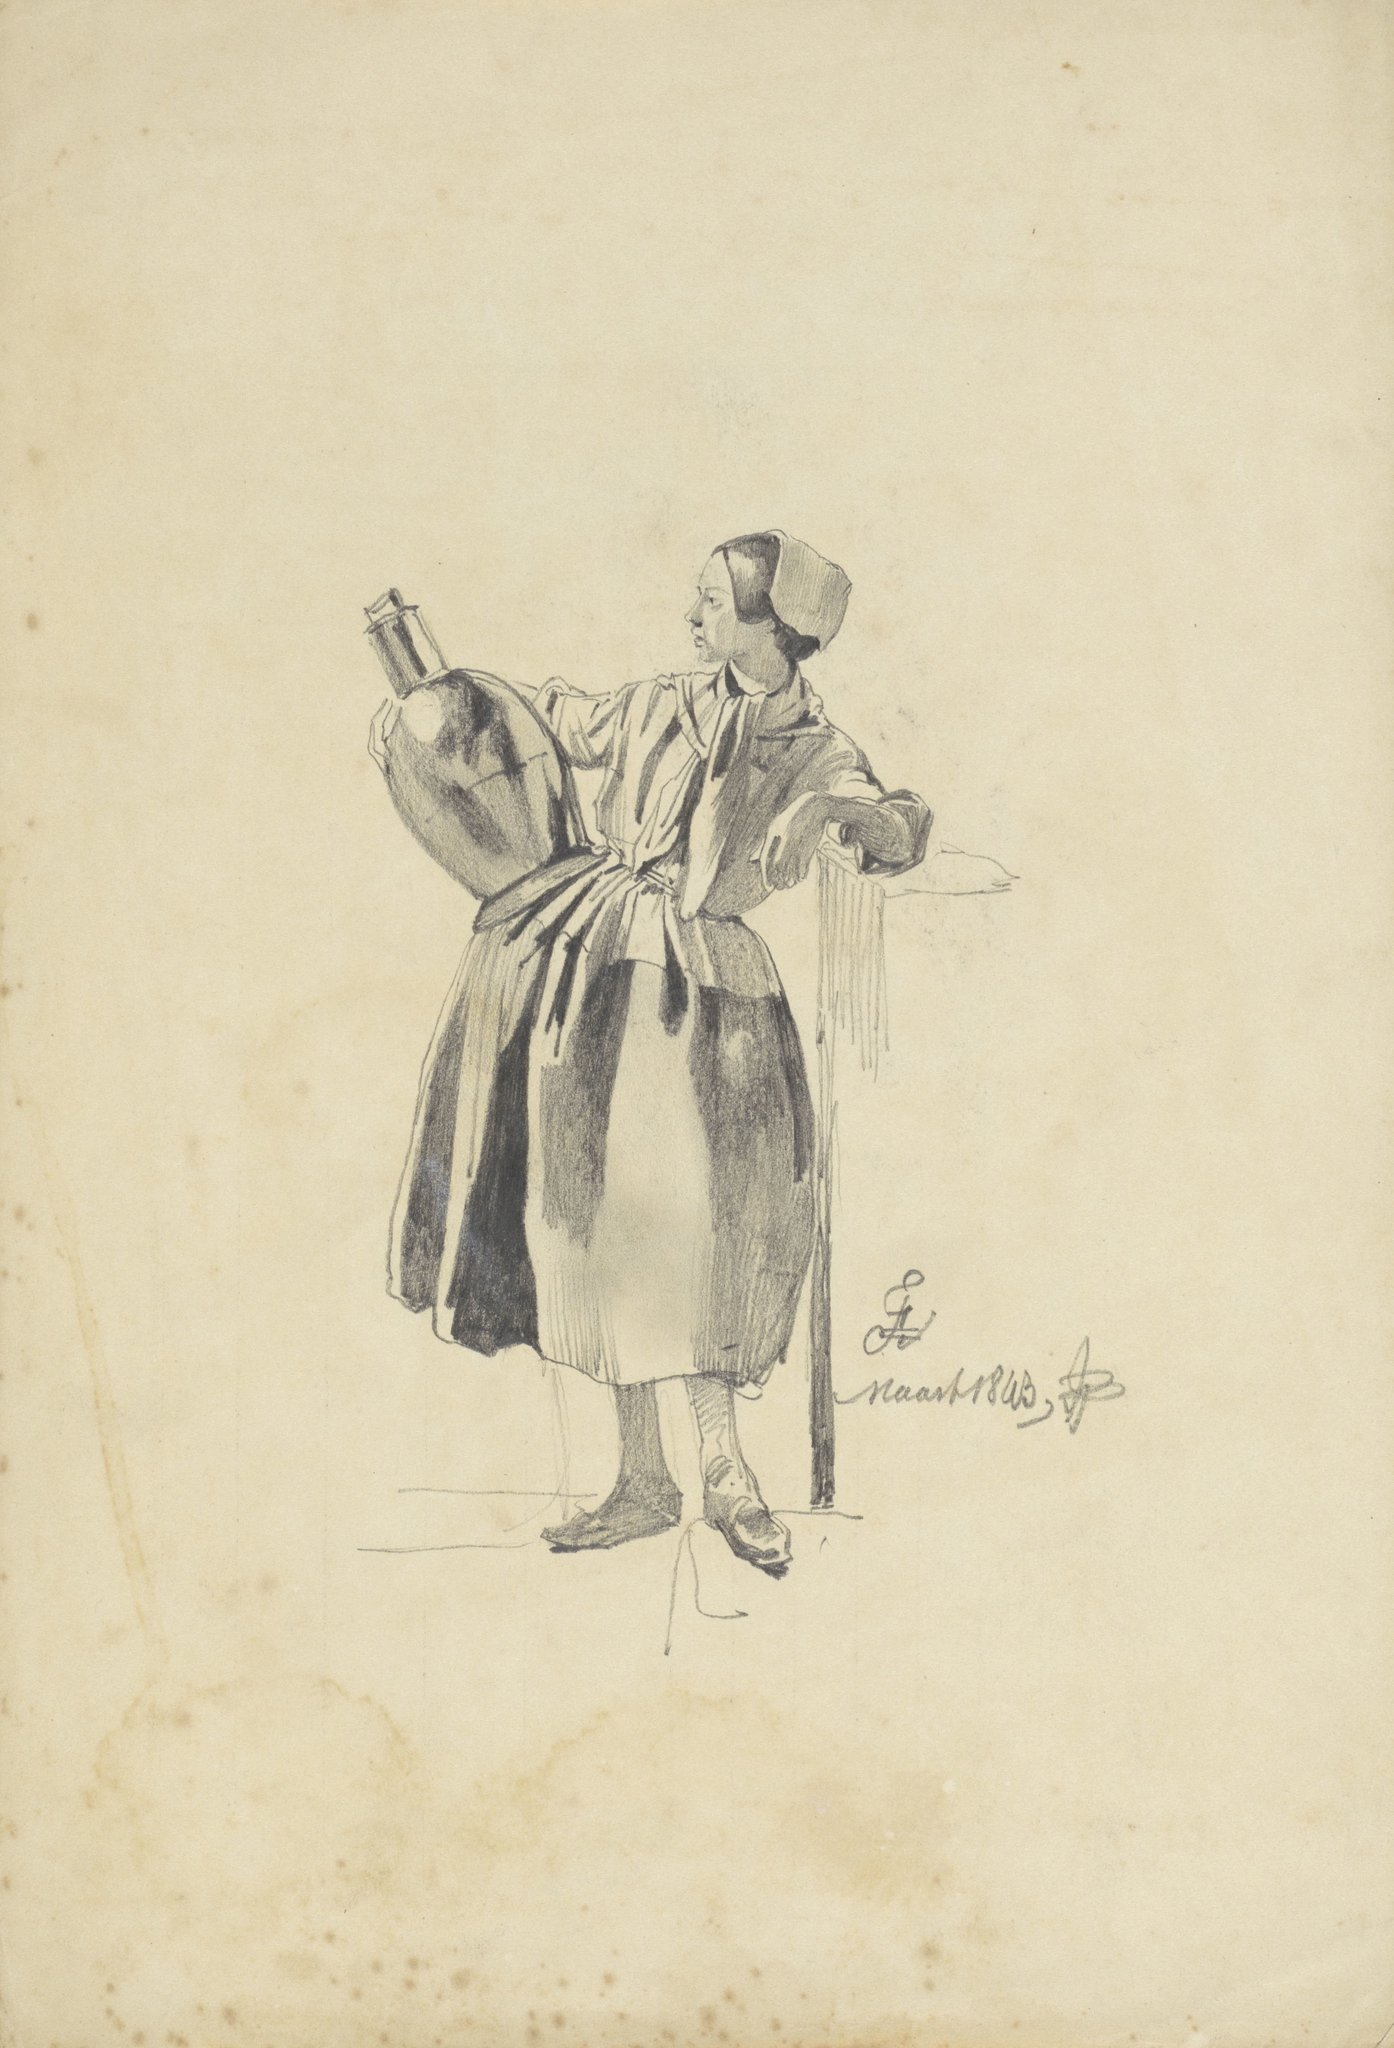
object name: drawing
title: Staand meisje met een kruik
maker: pieter van loon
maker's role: draughtsman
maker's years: 1801-1873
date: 1803-1843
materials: paper, pencil